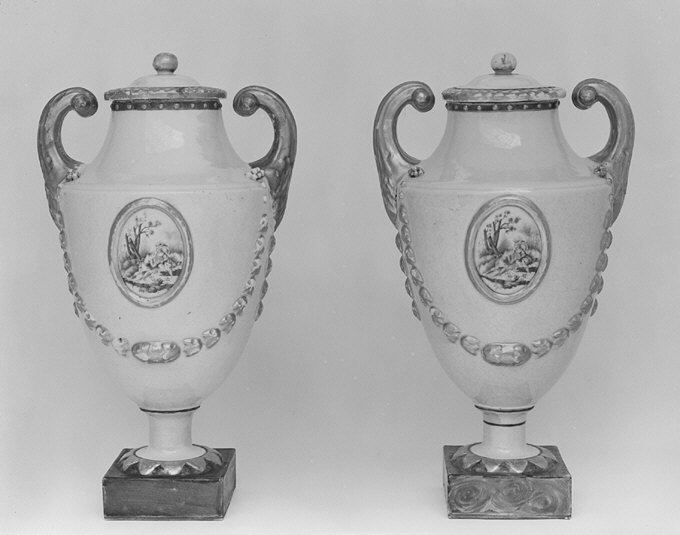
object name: urn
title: Urn (one of a pair)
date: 1775-1785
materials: hard paste porcelain